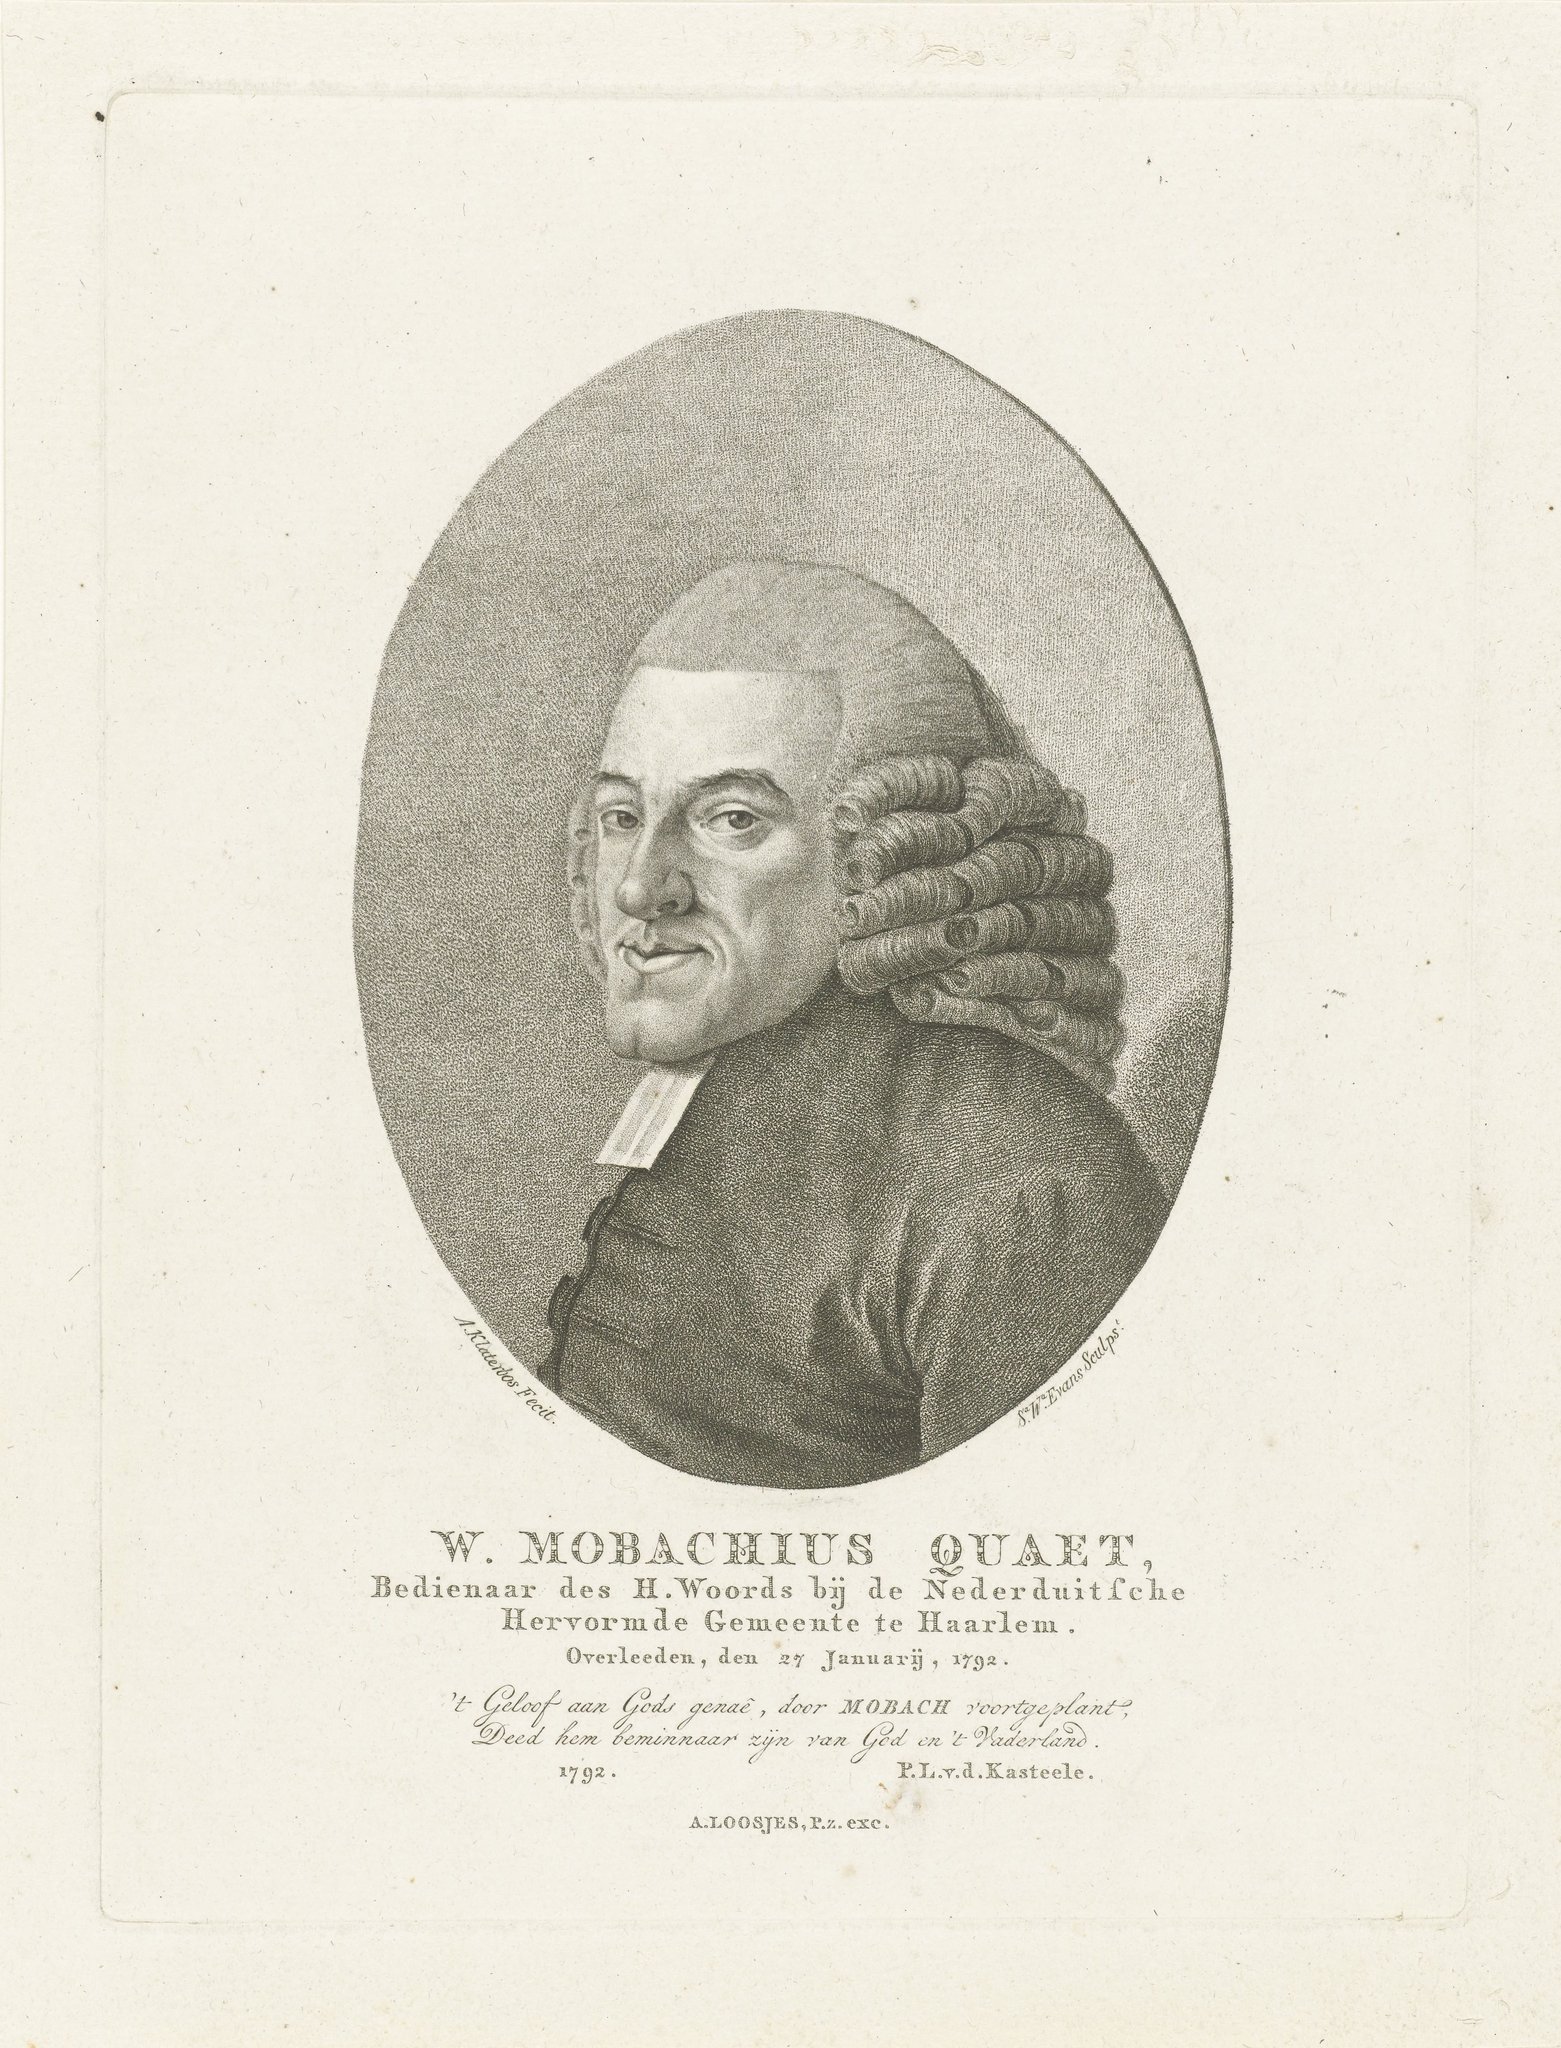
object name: print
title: Portret van W. Mobachius Quaet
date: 1792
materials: paper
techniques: stippled etching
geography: rotterdam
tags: den bosch, haarlem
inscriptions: collector's mark: Lugt 2228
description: Ovaal busteportret van Wilhelmus Mobachius Quaet, predikant te Den Bosch en Haarlem. Onder de voorstelling een Nederlandse tekst.